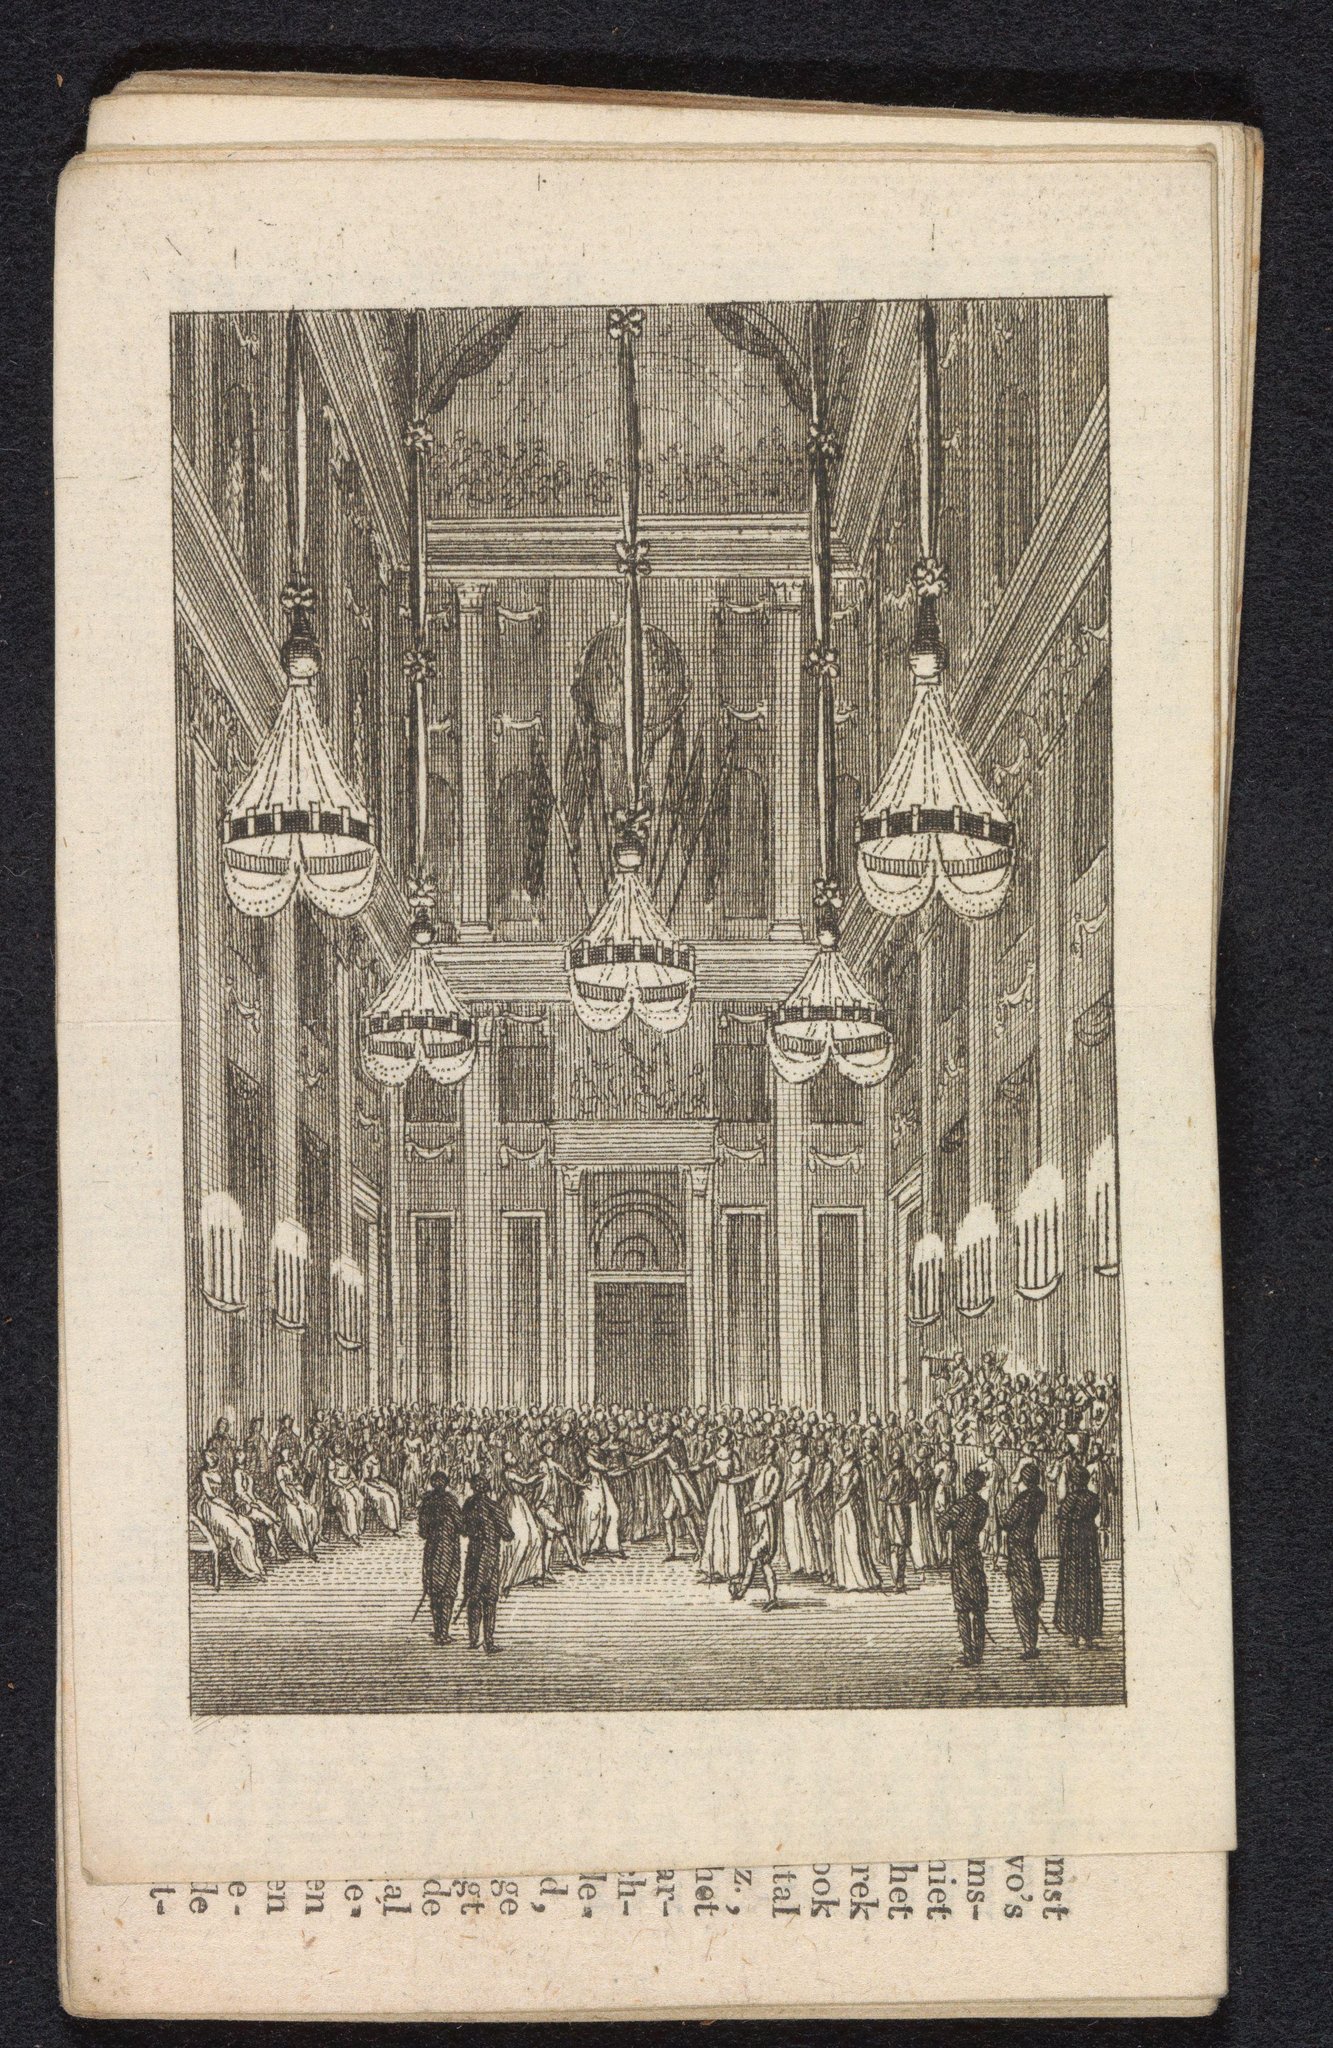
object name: print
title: Bal in het Paleis op de Dam, 1816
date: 1816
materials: paper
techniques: engraving, etching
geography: netherlands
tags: anna paulowna romanowa, the hague, william ii of the netherlands, triumphal entry and public reception, pageant, 'entrée solennelle', 'joyeuse entrée' (+ dancing ~ festive activities), group dancing among upper classes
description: Bal in de Burgerzaal van het Paleis op de Dam, onderdeel van de feestelijkheden georganiseerd ter gelegenheid van de intocht van de prins en prinses van Oranje in Amsterdam, 23 september 1816. Behoort tot de vier illustraties in de Nederlandsche Oranje almanak voor 1817.